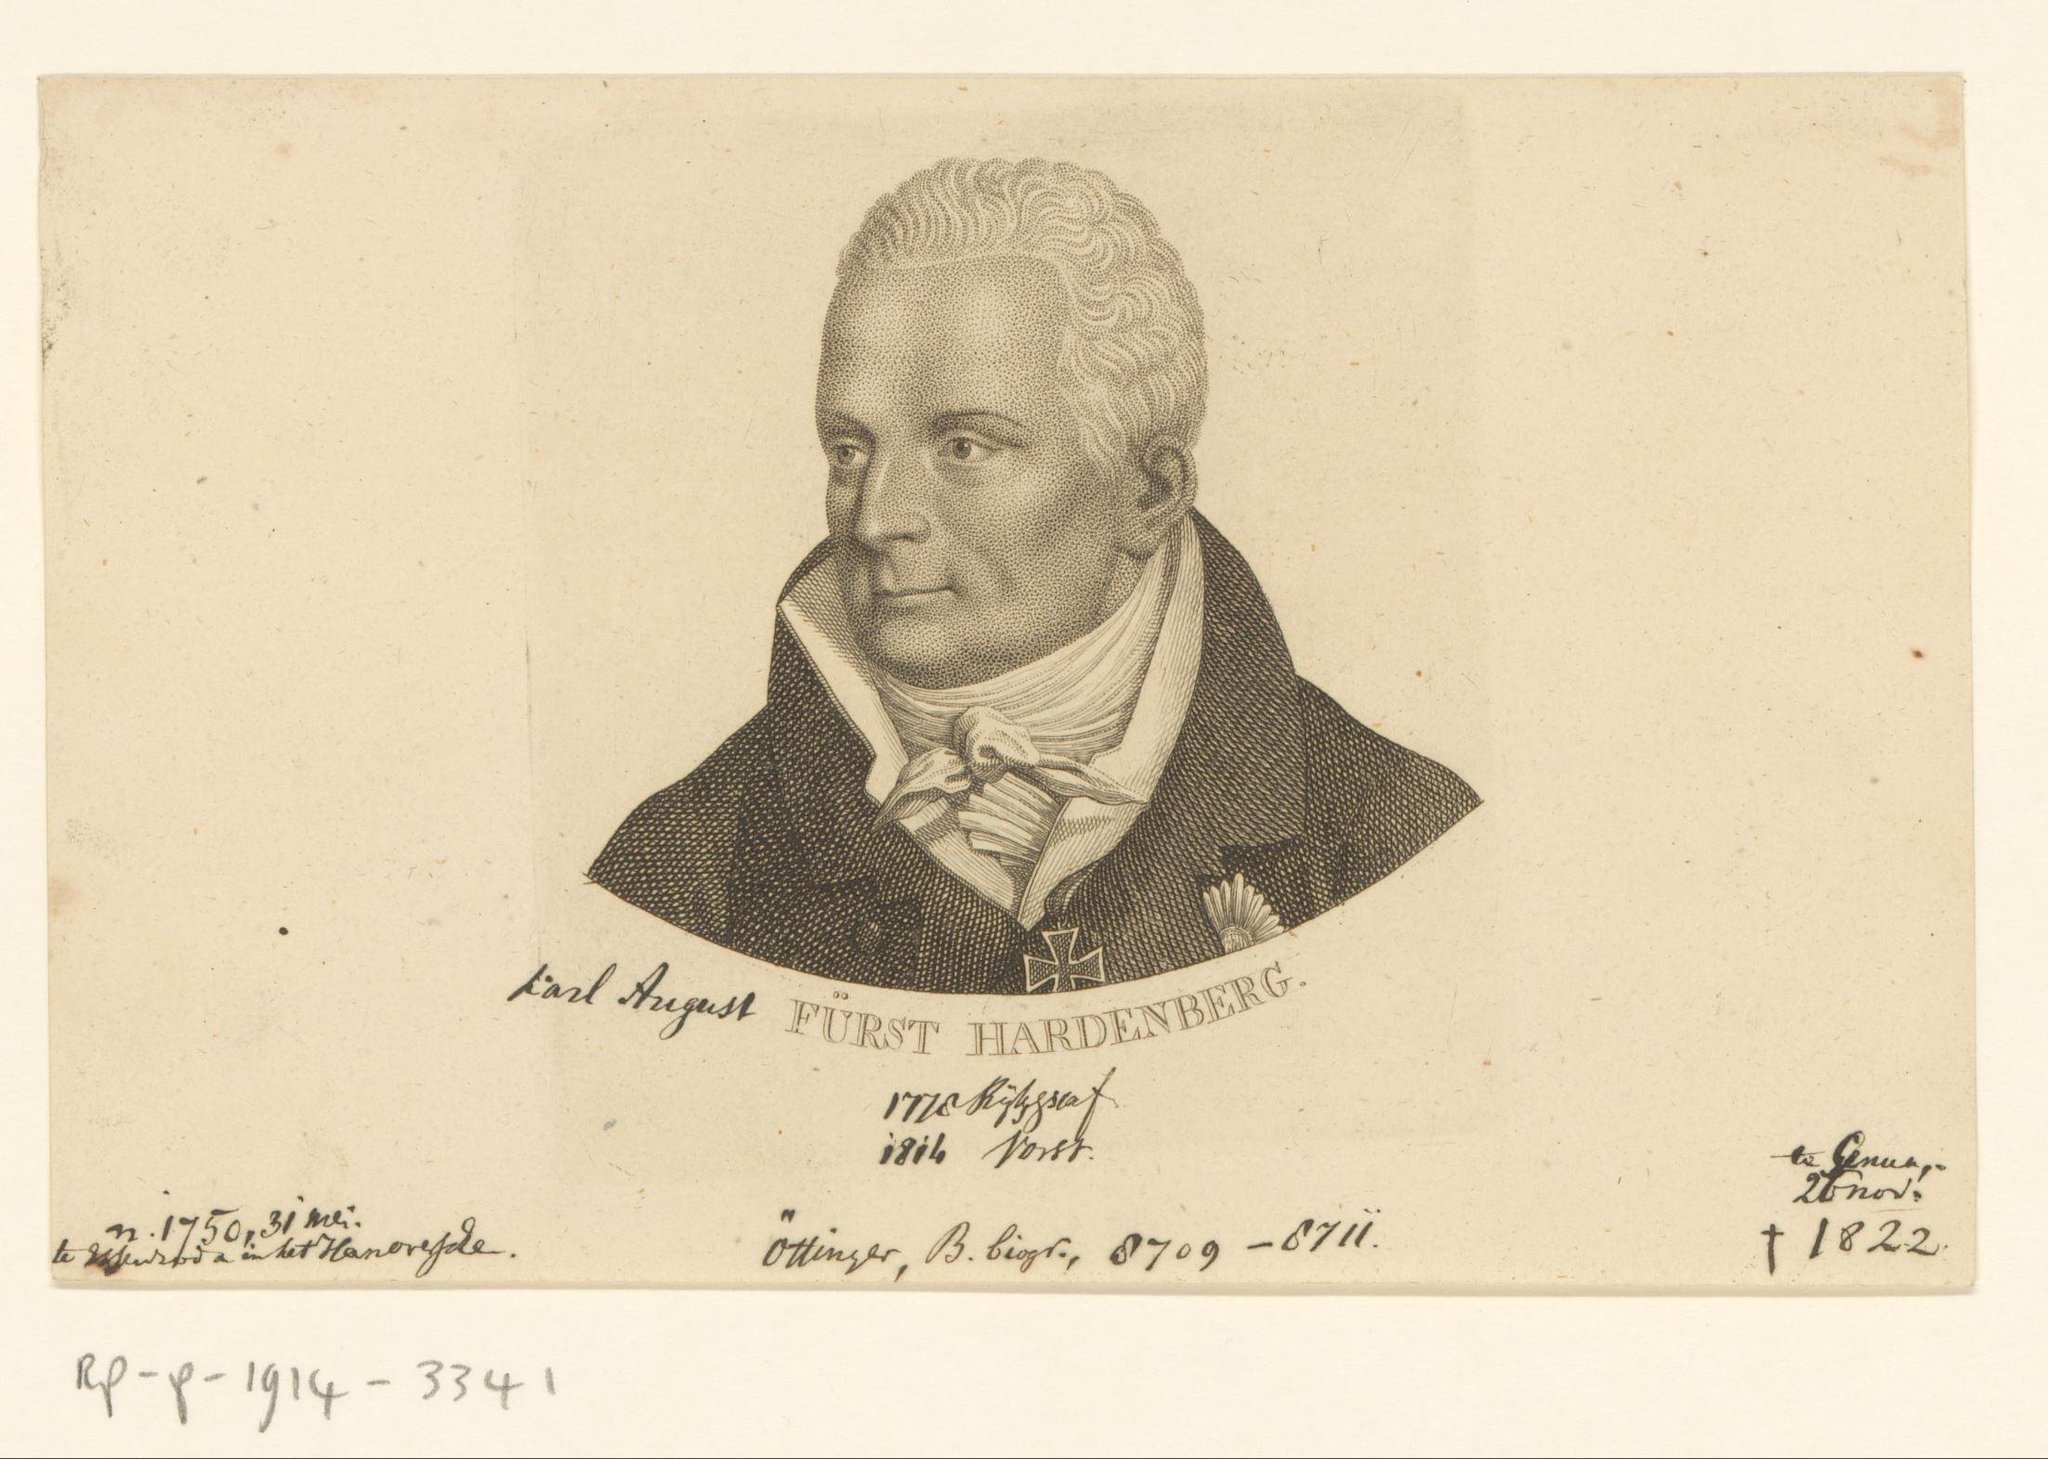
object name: print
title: Portret van Karl August von Hardenberg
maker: ernst ludwig riepenhausen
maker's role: print maker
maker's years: 1765-1840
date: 1775-1840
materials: paper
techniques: engraving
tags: historical persons, medals and other marks of military honour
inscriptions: collector's mark: Lugt 2228